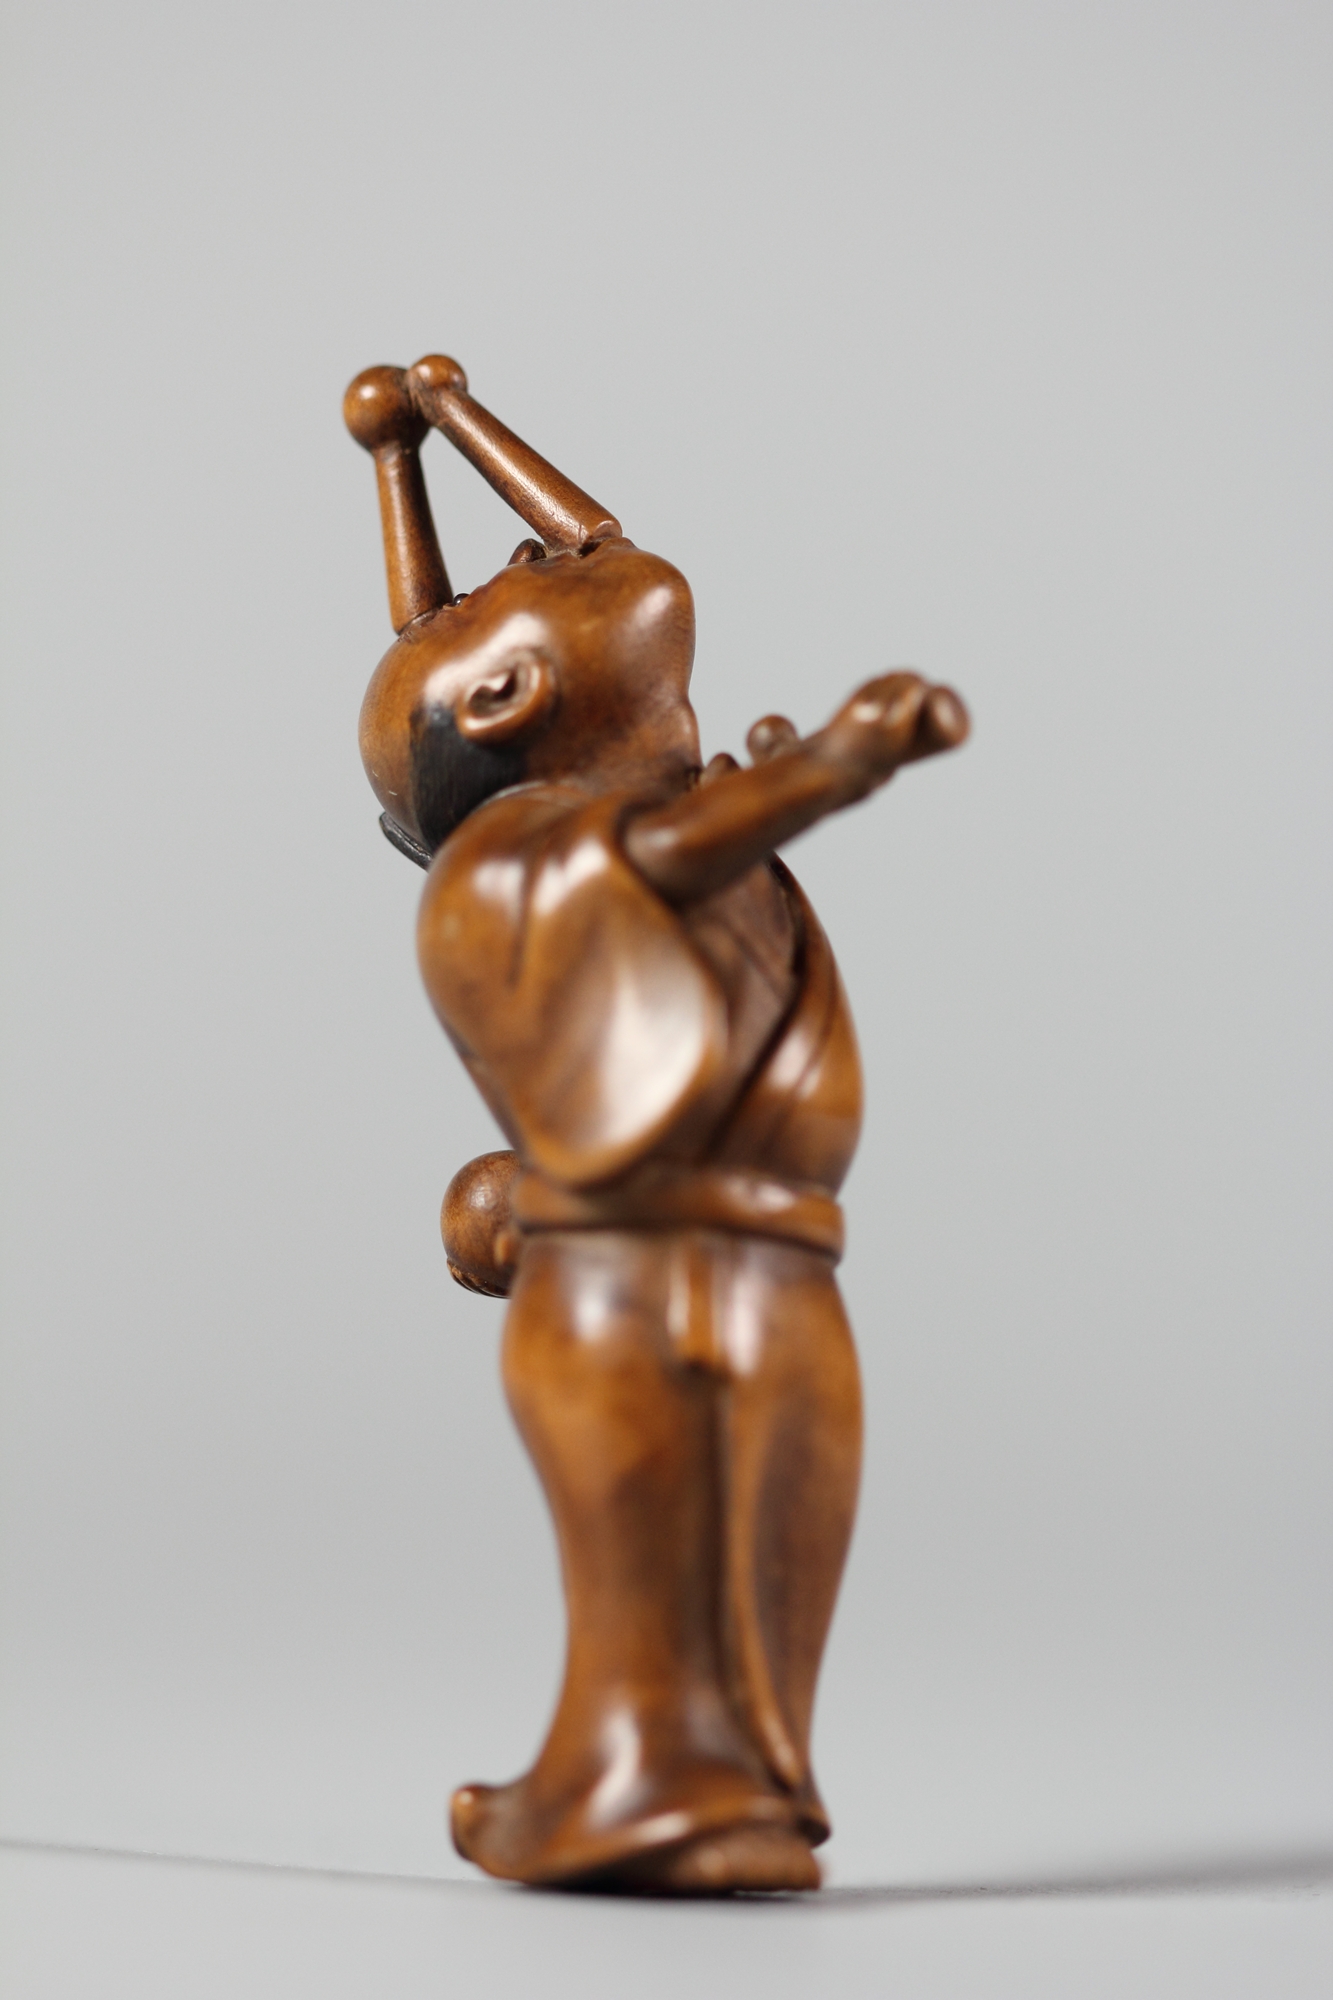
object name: netsuke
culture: japanese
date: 1801-1900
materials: wood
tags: men